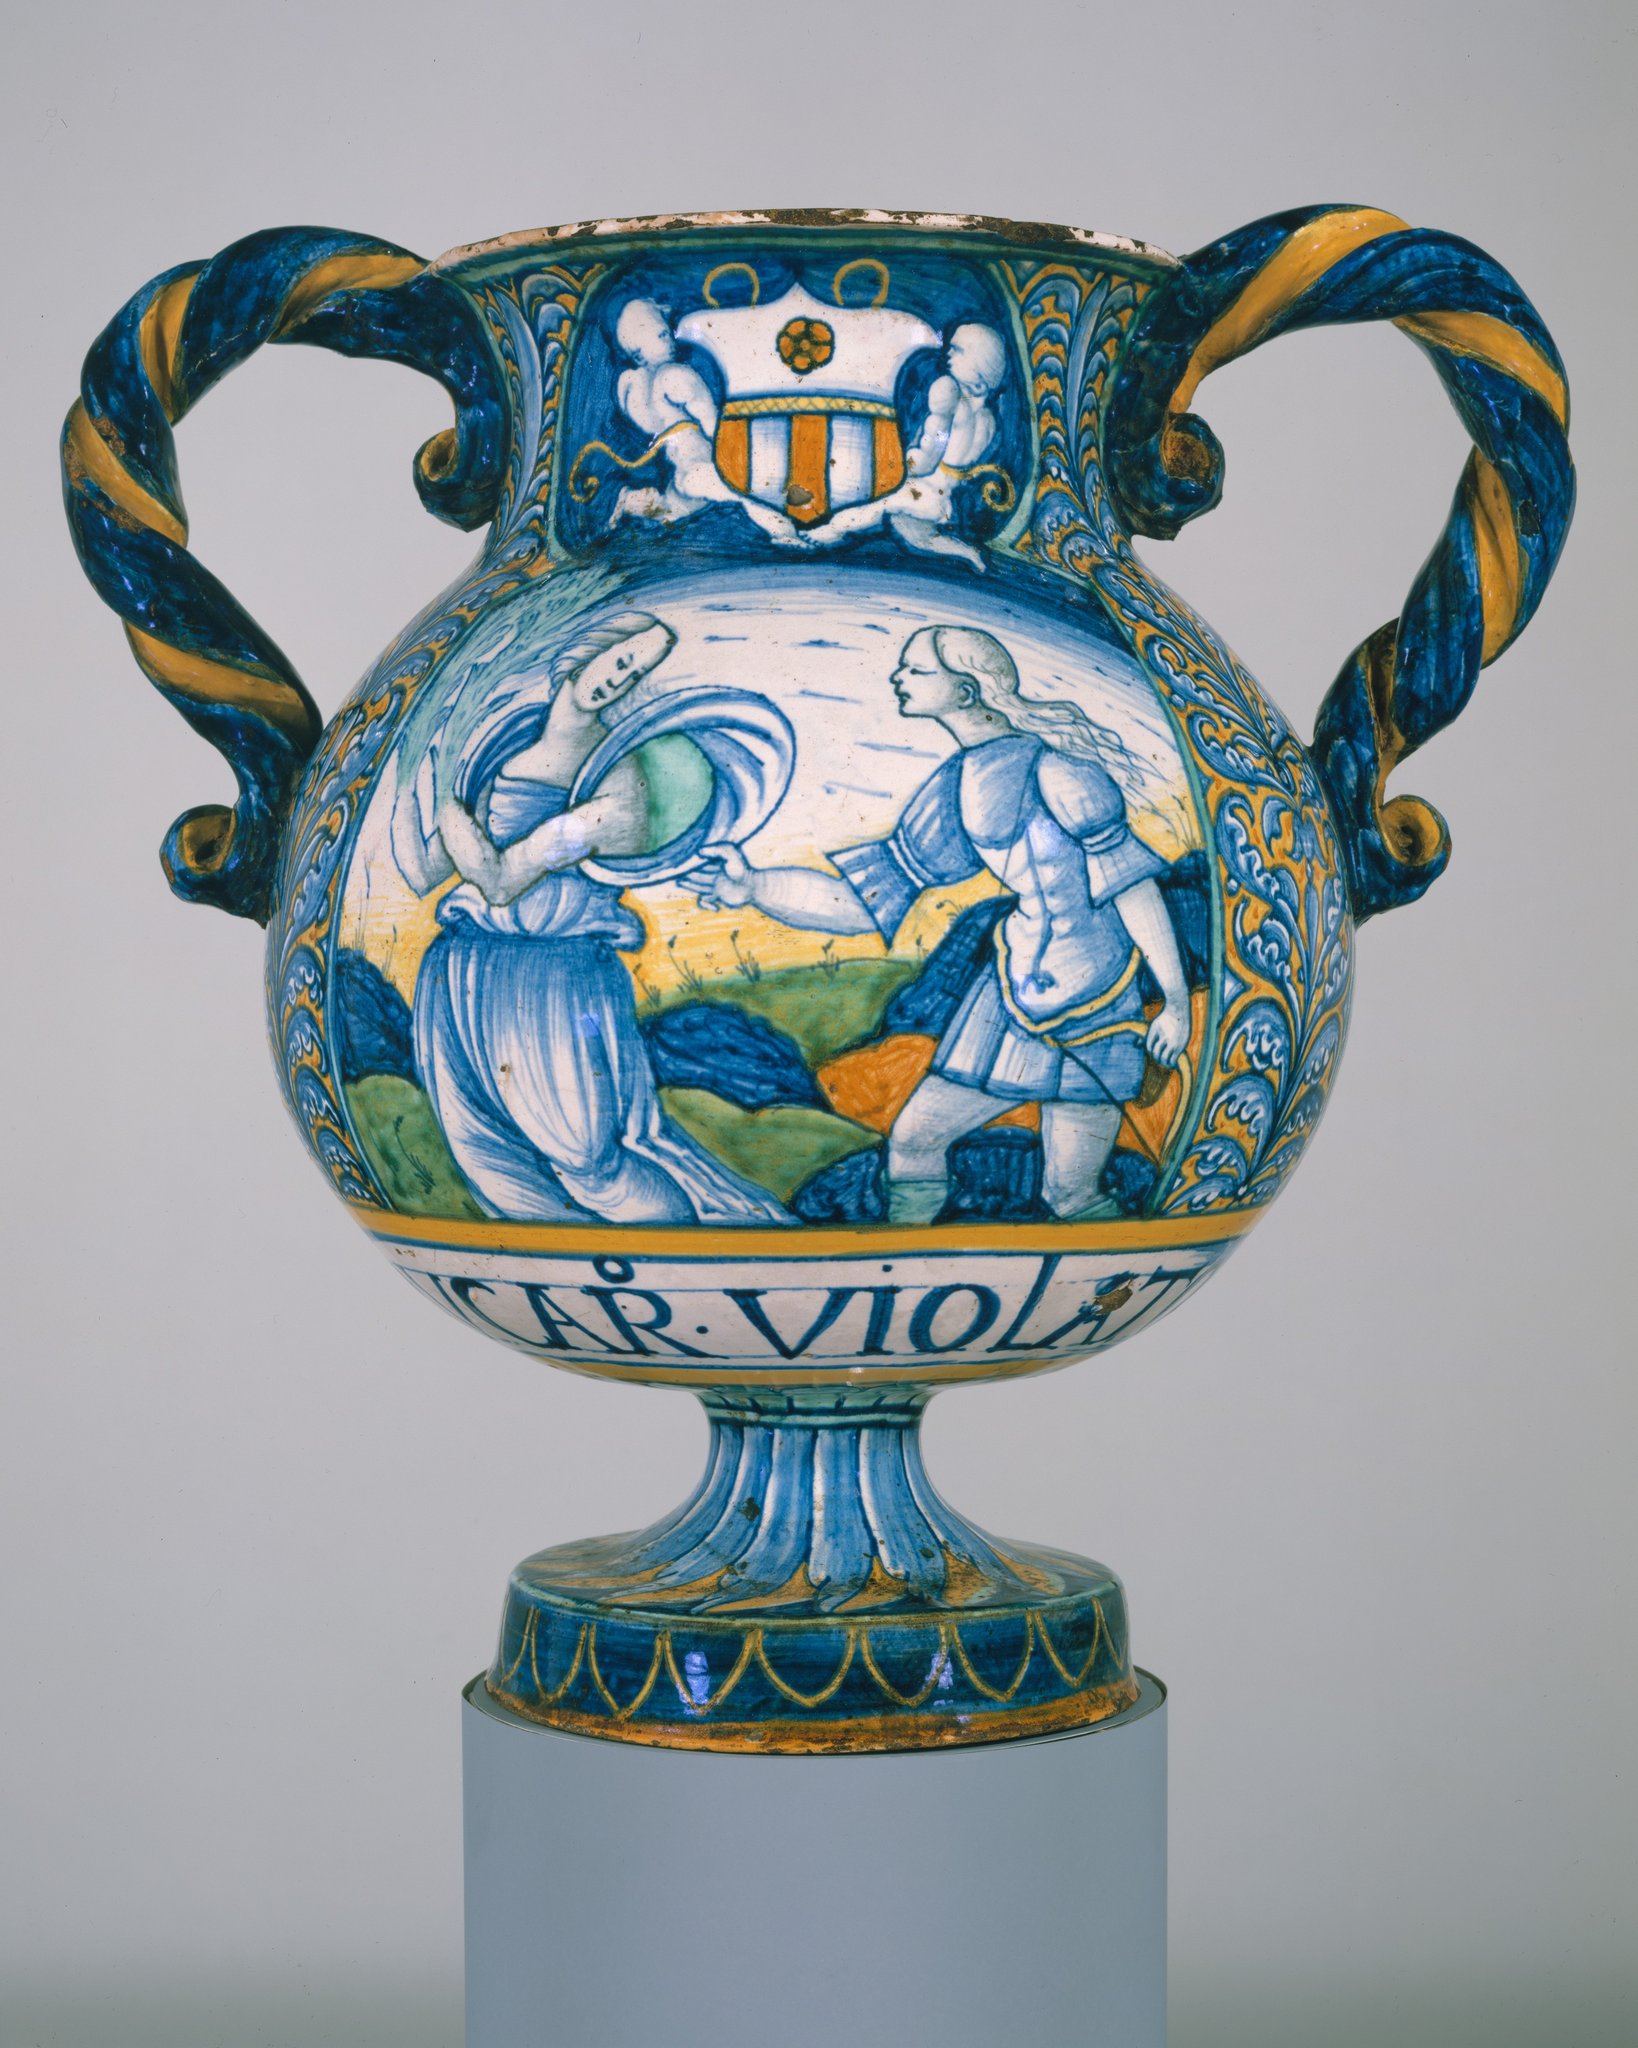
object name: apothecary vase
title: Apothecary Vase (vaso da farmacia)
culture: italian, castelli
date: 1515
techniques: maiolica, glazing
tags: men,women,coat of arms